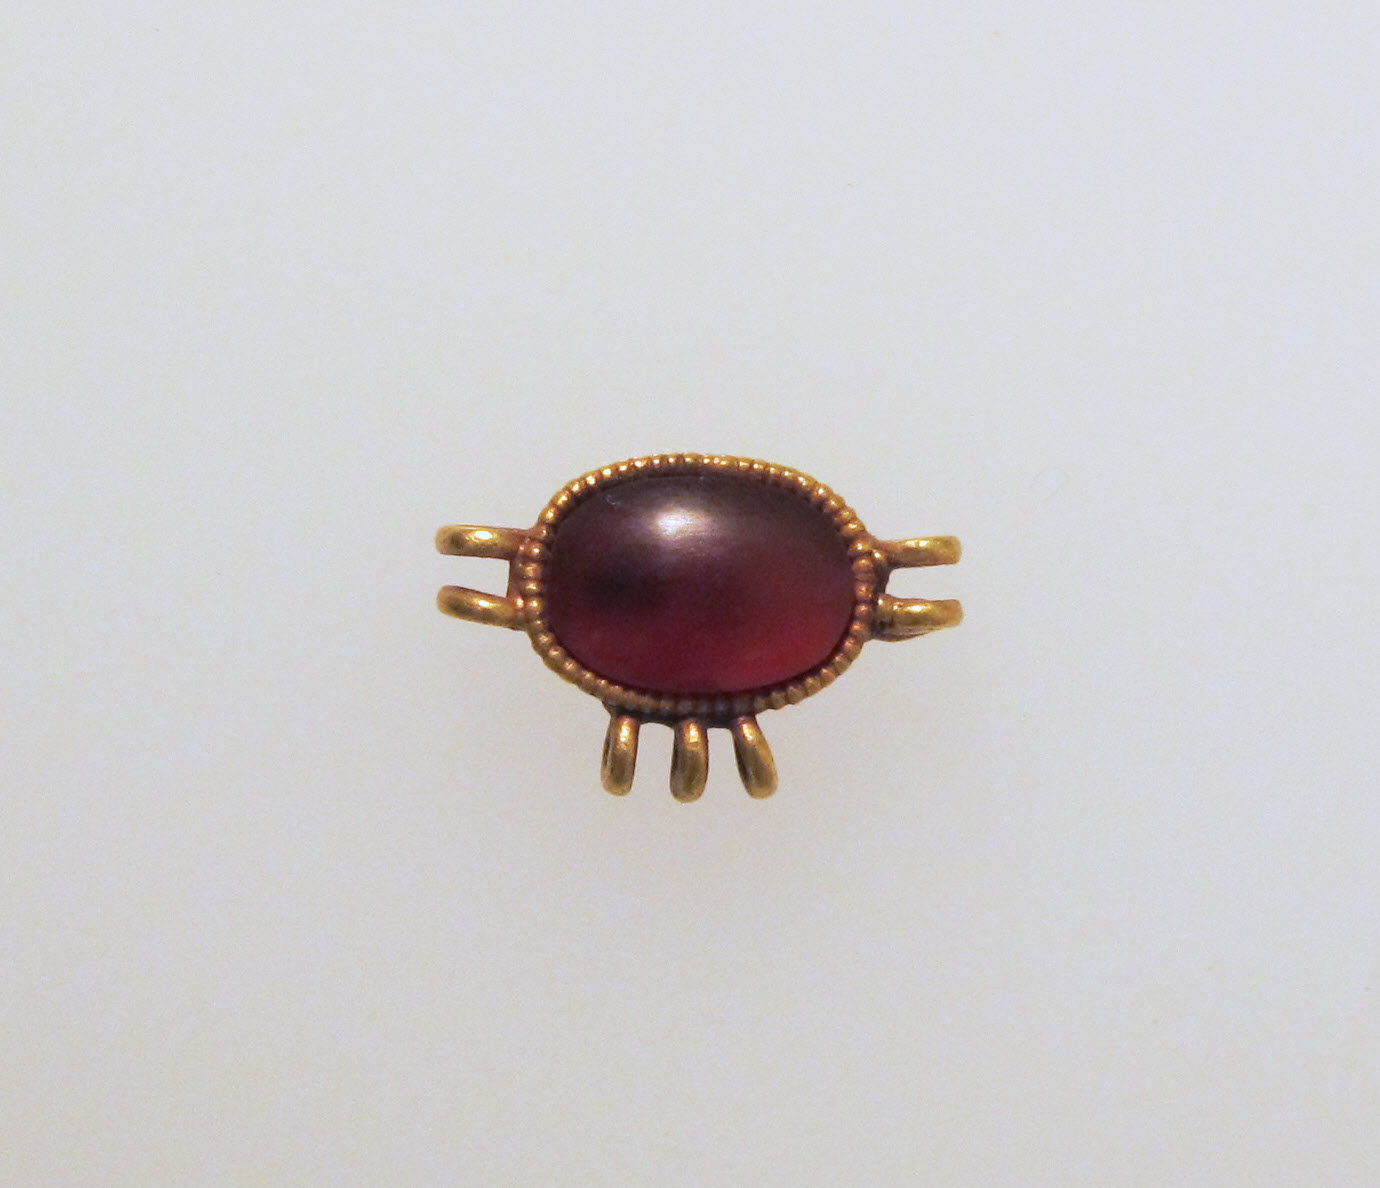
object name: bead, control with scaraboid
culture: cypriot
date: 3900 BCE-100 CE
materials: gold